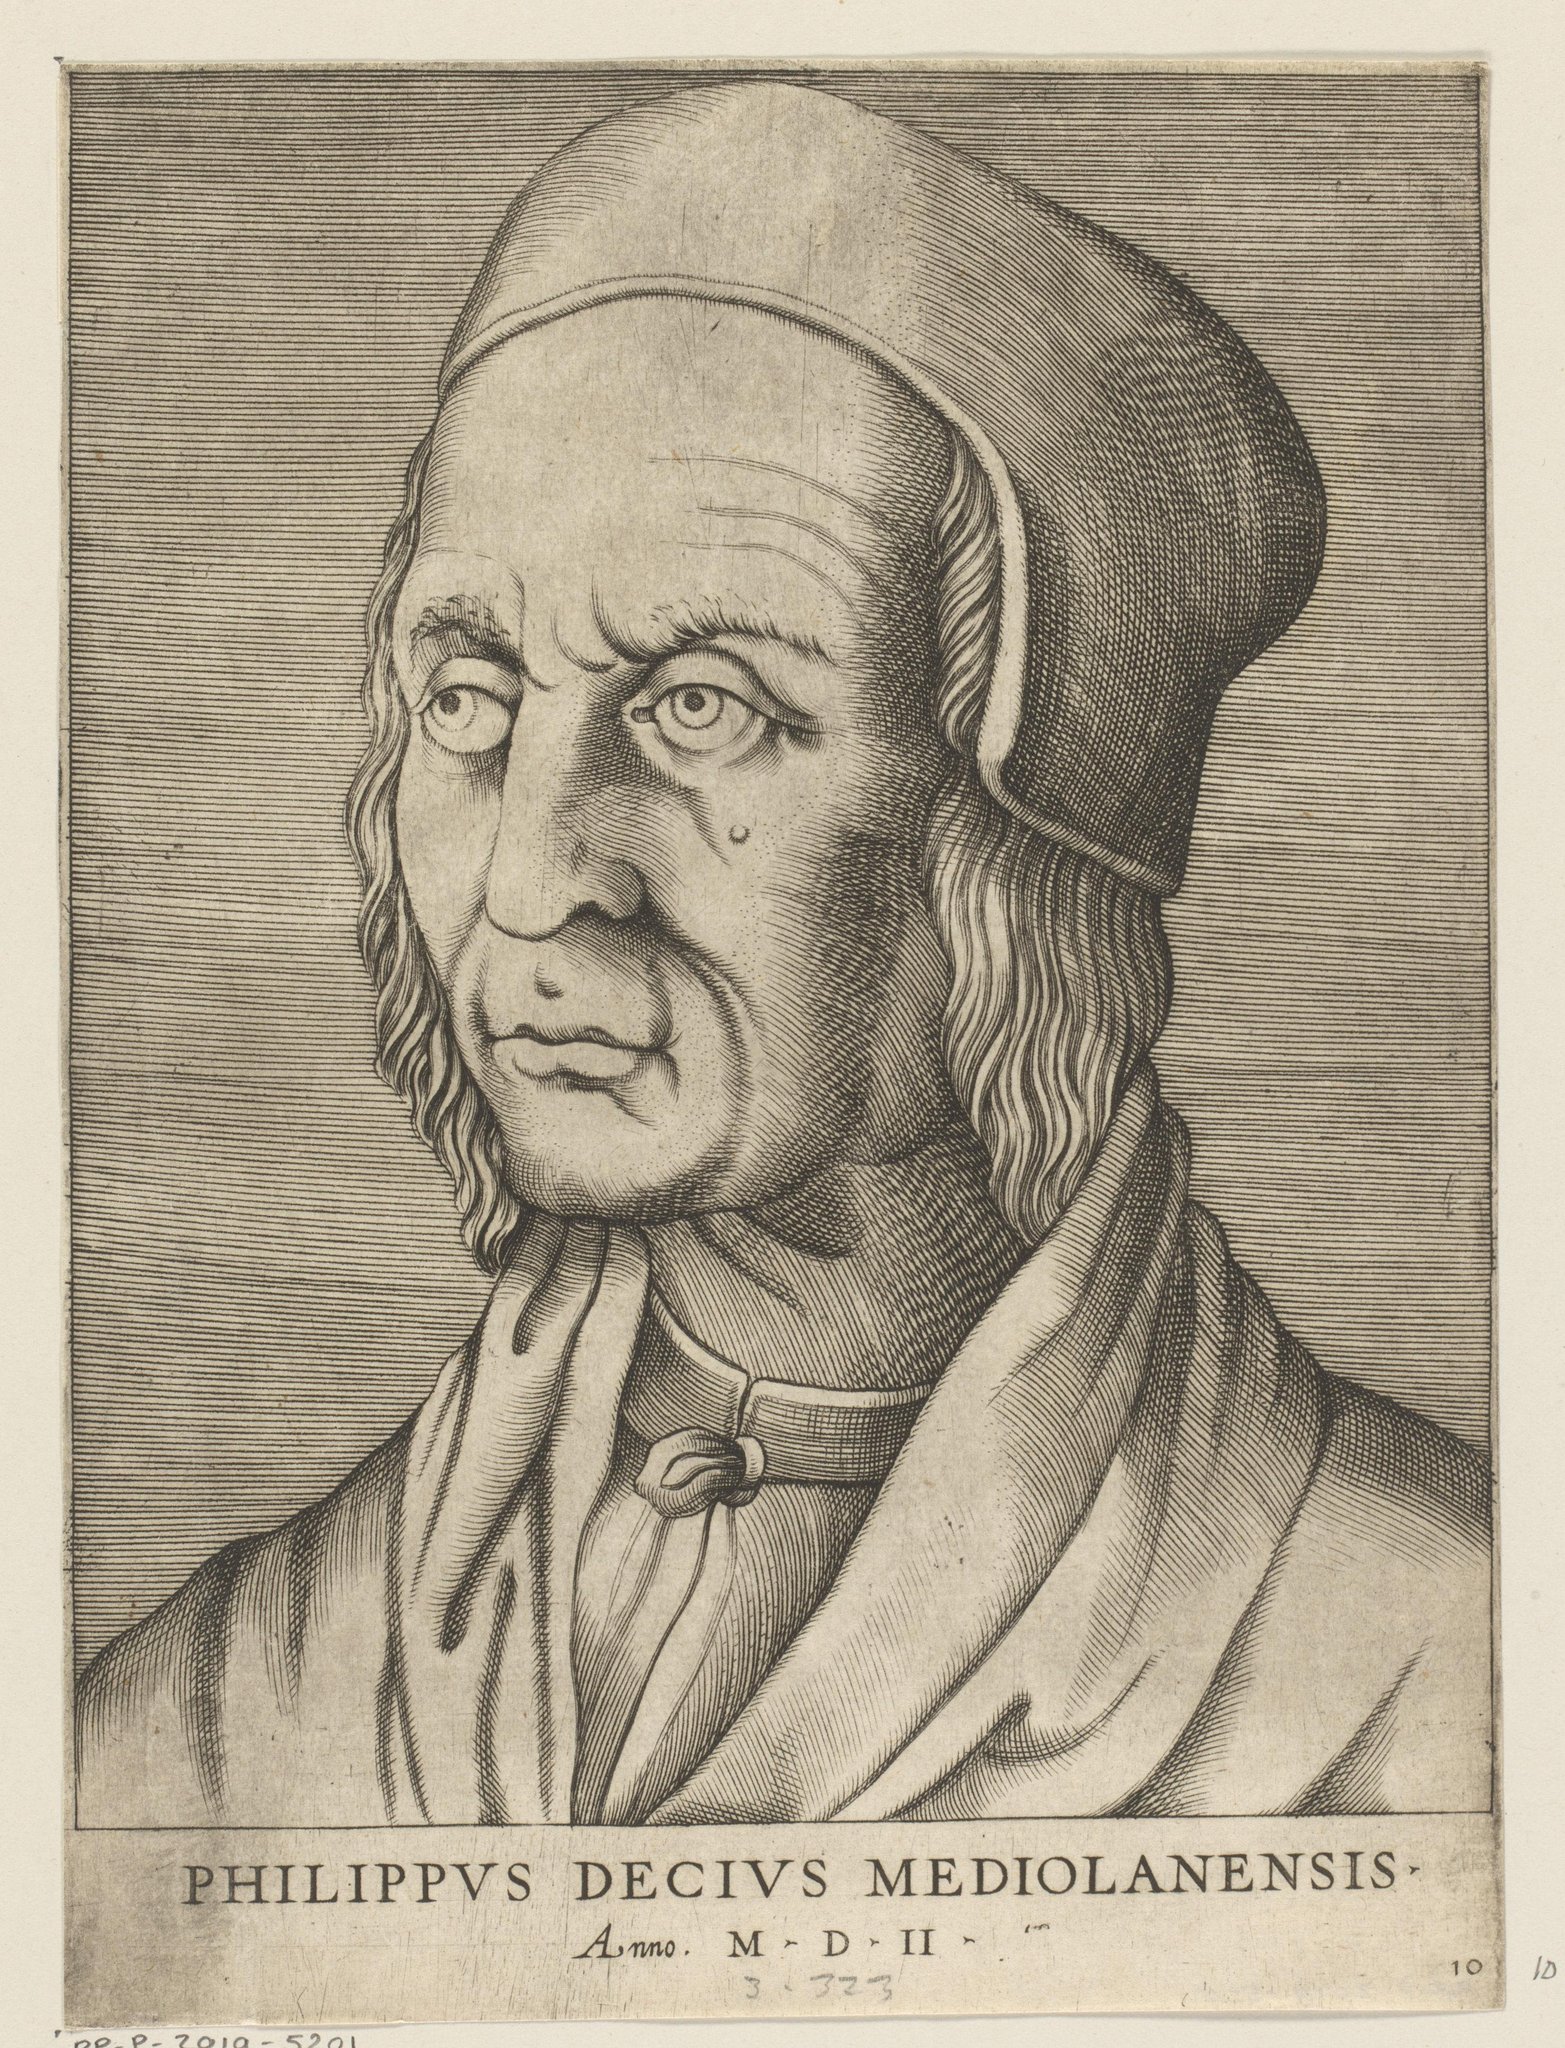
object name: print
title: Portretten van nobele juristen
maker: Anonymous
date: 1566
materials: paper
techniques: engraving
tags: historical persons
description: Prentserie voor het eerst uitgegeven te Rome door Antonio Lafreri in 1566. Serie waarschijnlijk opnieuw uitgegeven door Petri de' Nobili rond 1584-1585.